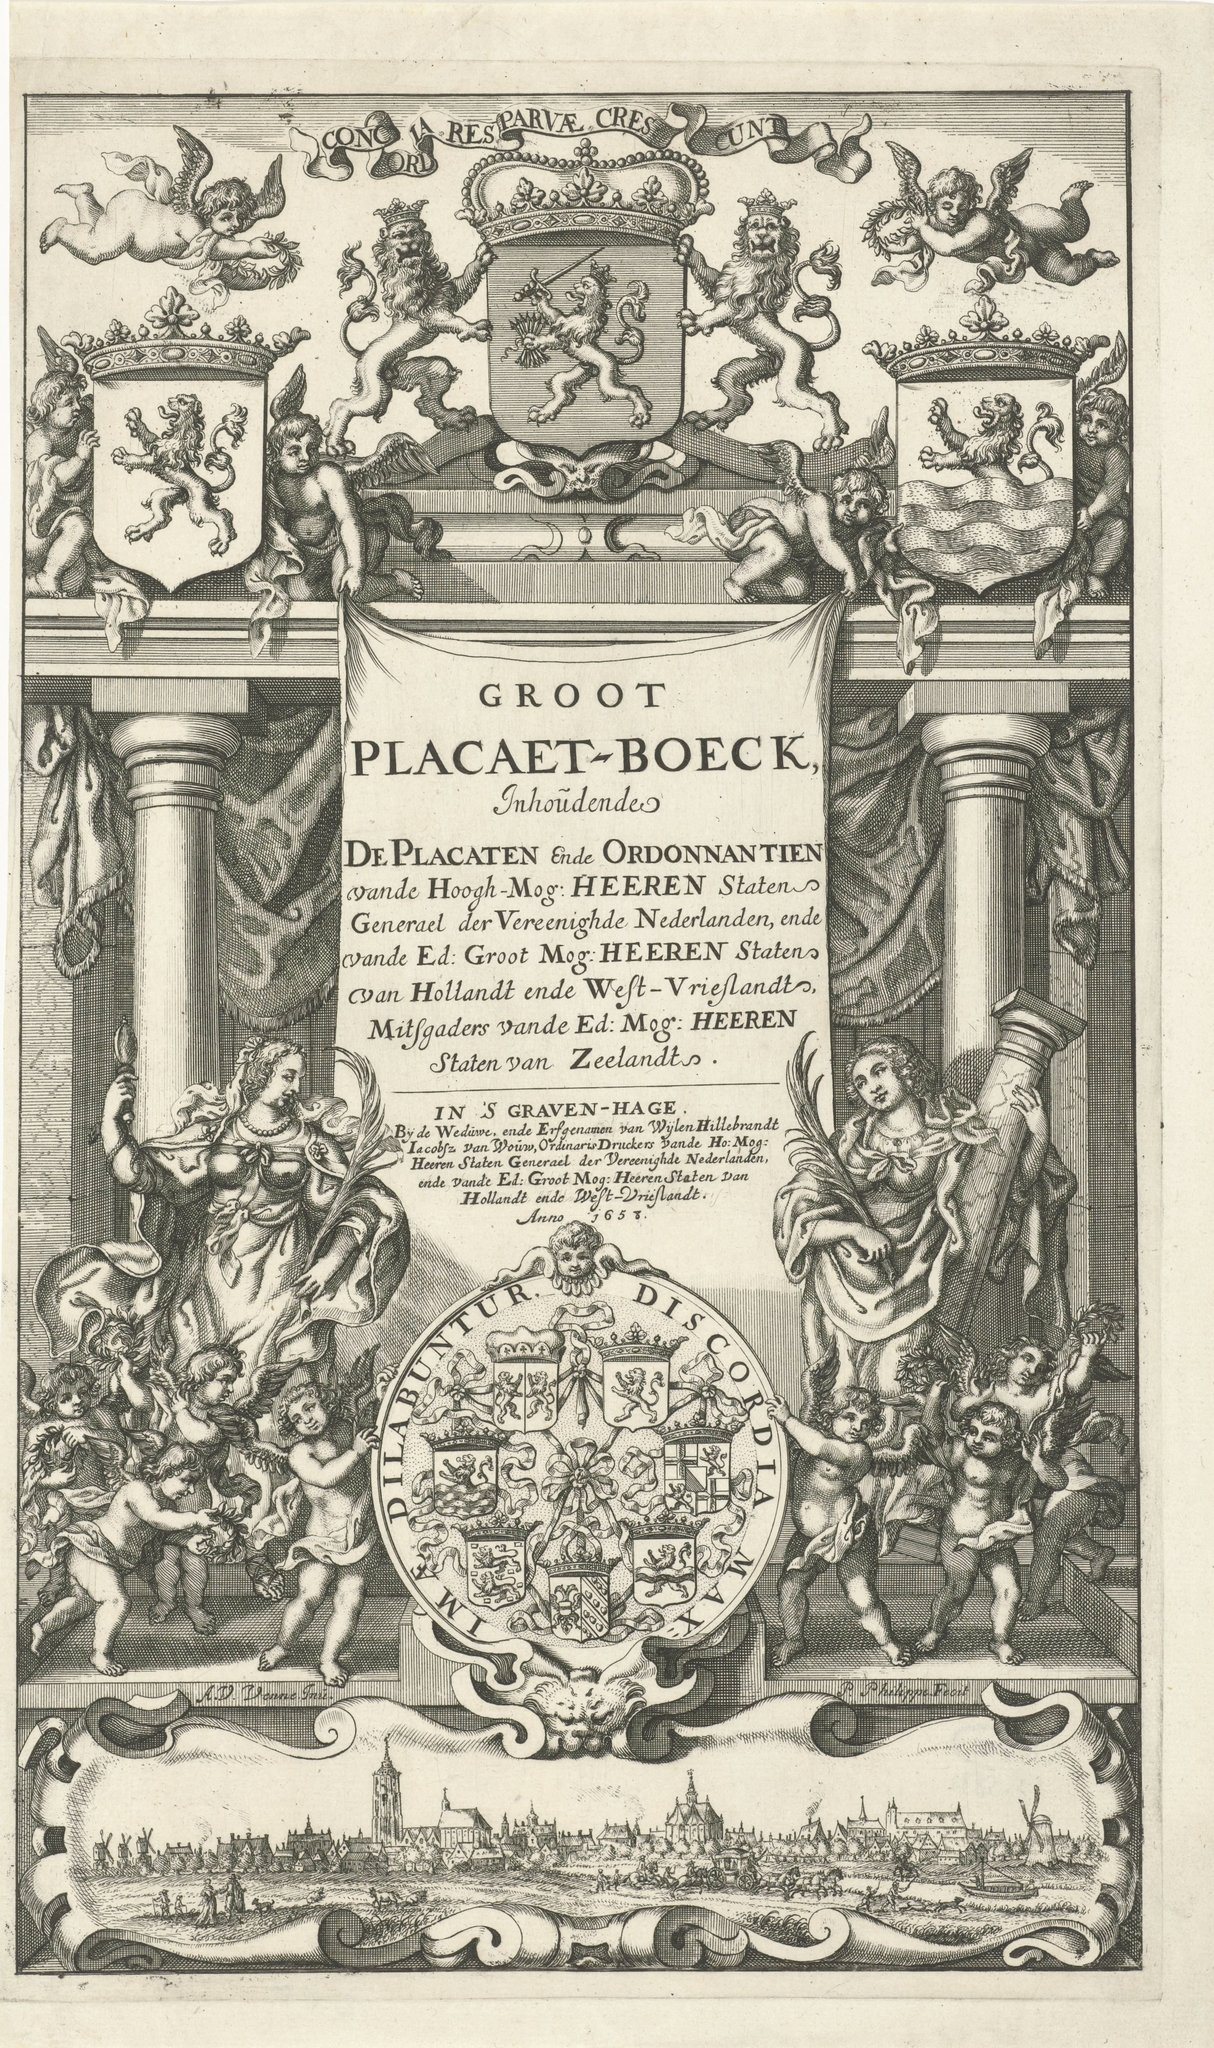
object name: print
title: Titelpagina voor: Groot Placaet-Boeck, 1658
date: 1658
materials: paper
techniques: engraving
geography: the hague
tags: fortitude, 'fortitudo' ~ one of the four cardinal virtues, prudence, 'prudentia'; 'prudenza' (ripa) ~ one of the four cardinal virtues, angels, the hague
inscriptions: collector's mark: Lugt 2228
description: Architecturale nis bekroond met het wapenschild van de Republiek der Zeven Verenigde Nederlanden, waarop engelen, van wie twee een doek met de titel in het Nederlands vasthouden. In de nis Voorzichtigheid en Kracht, te midden van engelen. Onderaan een cartouche met een gezicht op Den Haag.